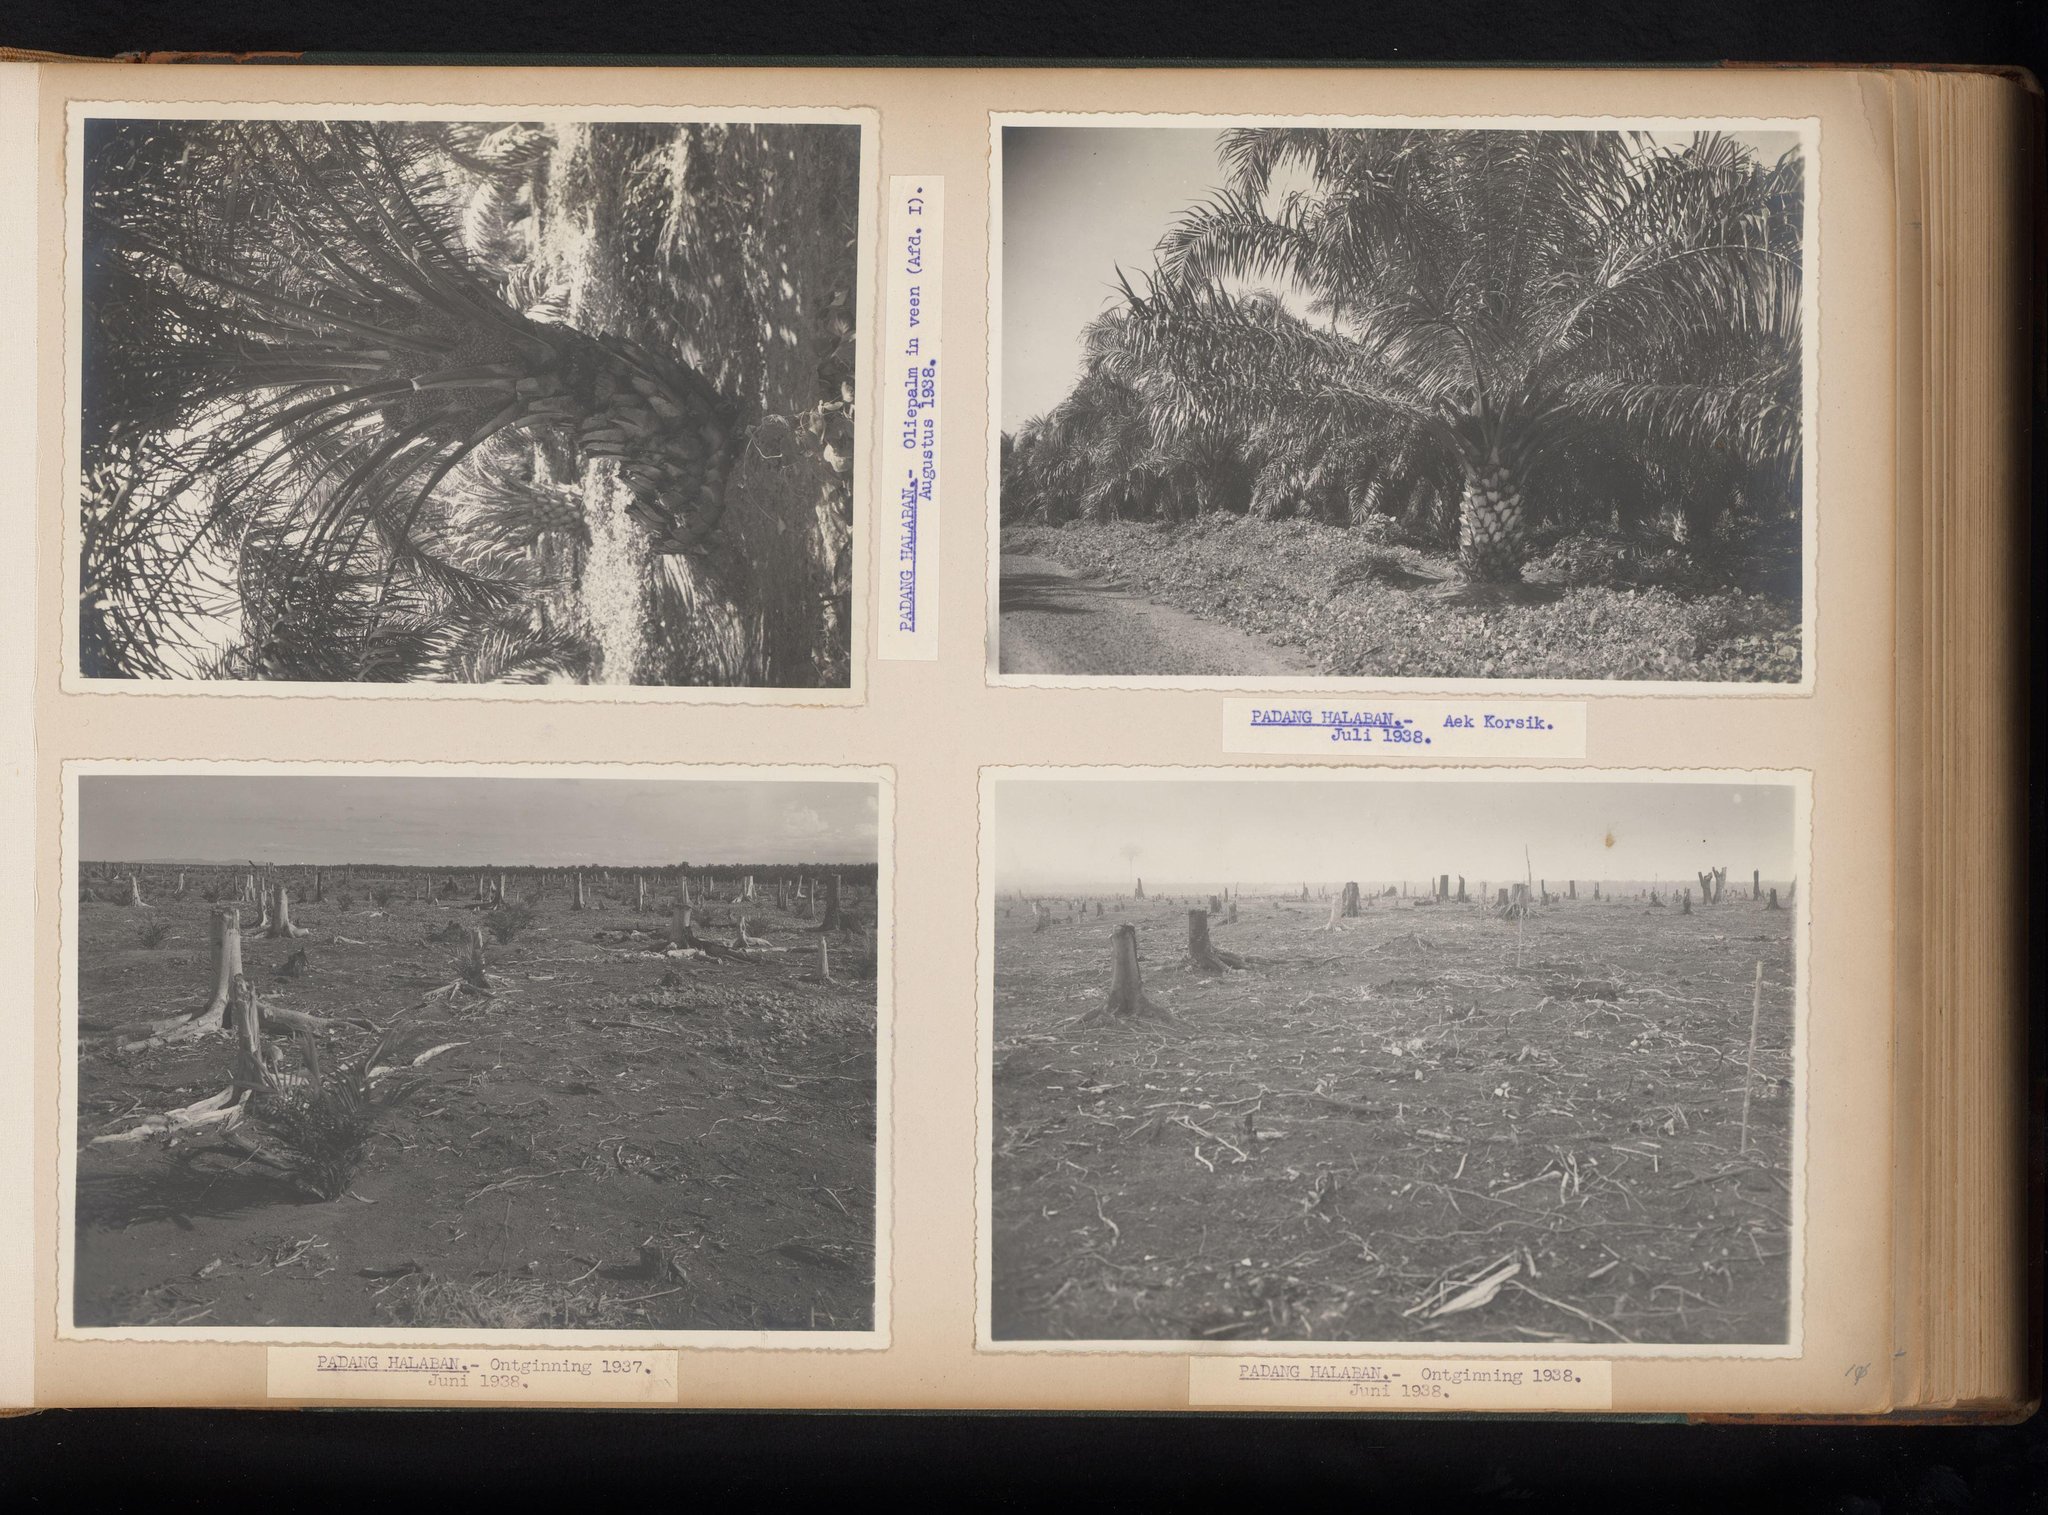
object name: album leaf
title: Oliepalmen en ontginning op Padang Halaban, 1938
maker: Anonymous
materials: cardboard, photographic support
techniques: gelatin silver print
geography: sumatra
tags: plantation, (non-fruit) products of plants or trees: palm oil, sumatra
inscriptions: inscription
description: Blad met vier foto's van oliepalmen en ontginning op Padang Halaban, 1938. Met etiketten met onderschriften onder de foto's. Onderdeel van het fotoalbum over de plantages Pernantian en Brussel van de Sumatra Caoutchouc Maatschappij op de Oostkust van Sumatra in de jaren 1935-1939.